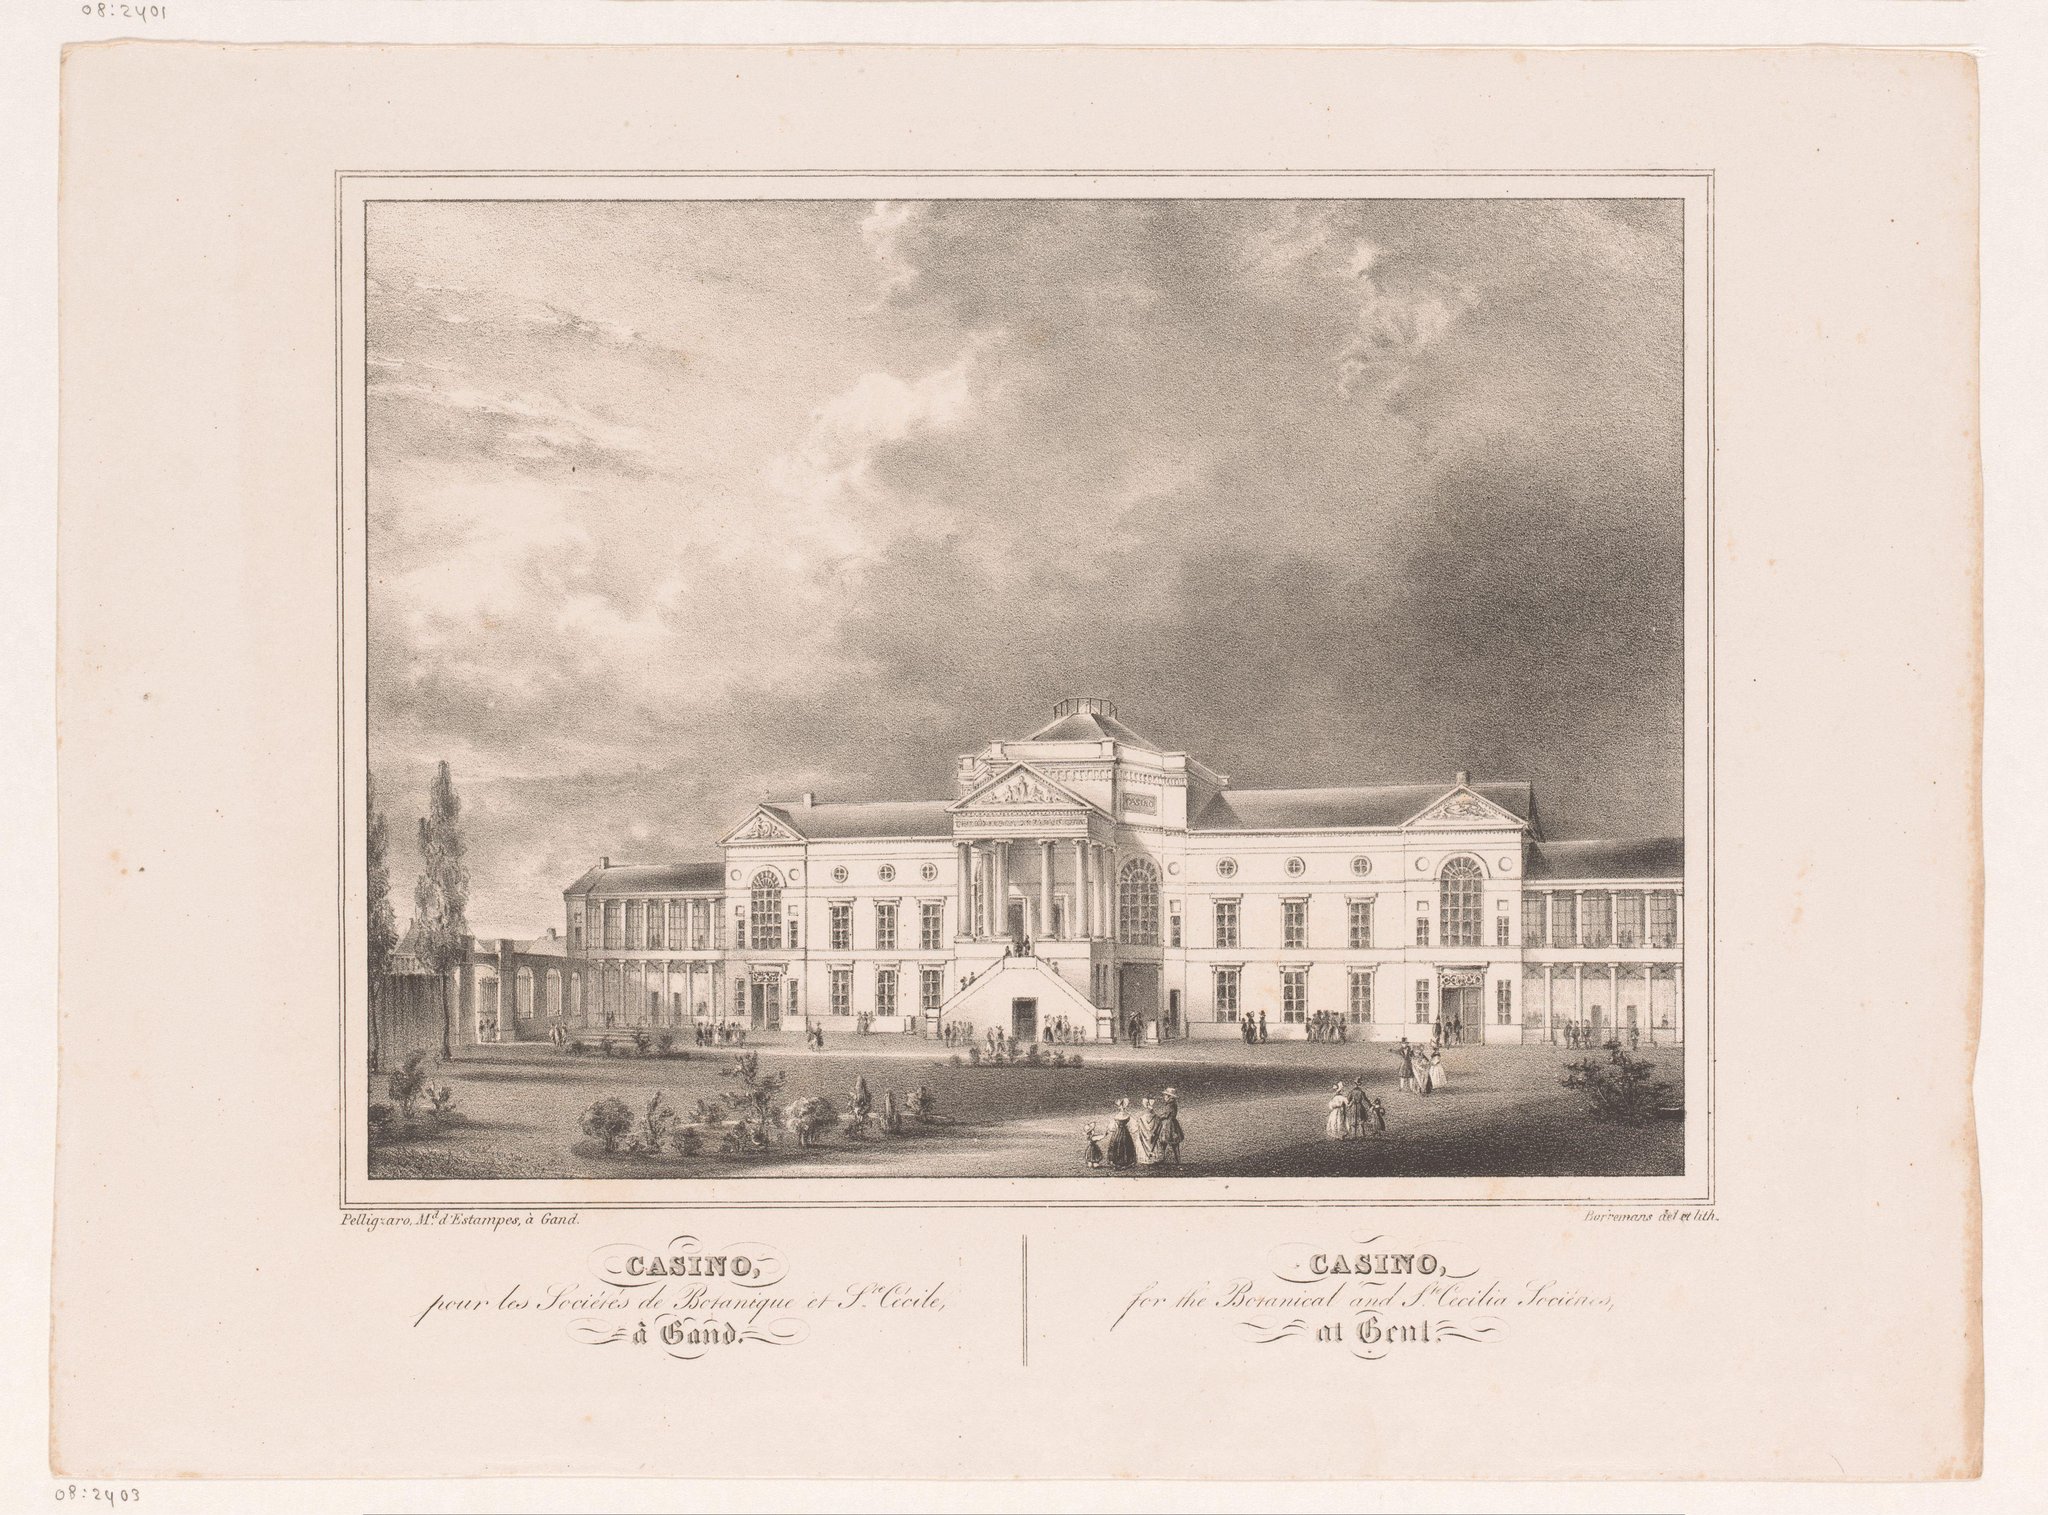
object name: print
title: Album des monumens de Gand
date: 1851-1870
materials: paper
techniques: lithograph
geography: ghent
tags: civic architecture; edifices; dwellings, ghent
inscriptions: collector's mark: Lugt 2228